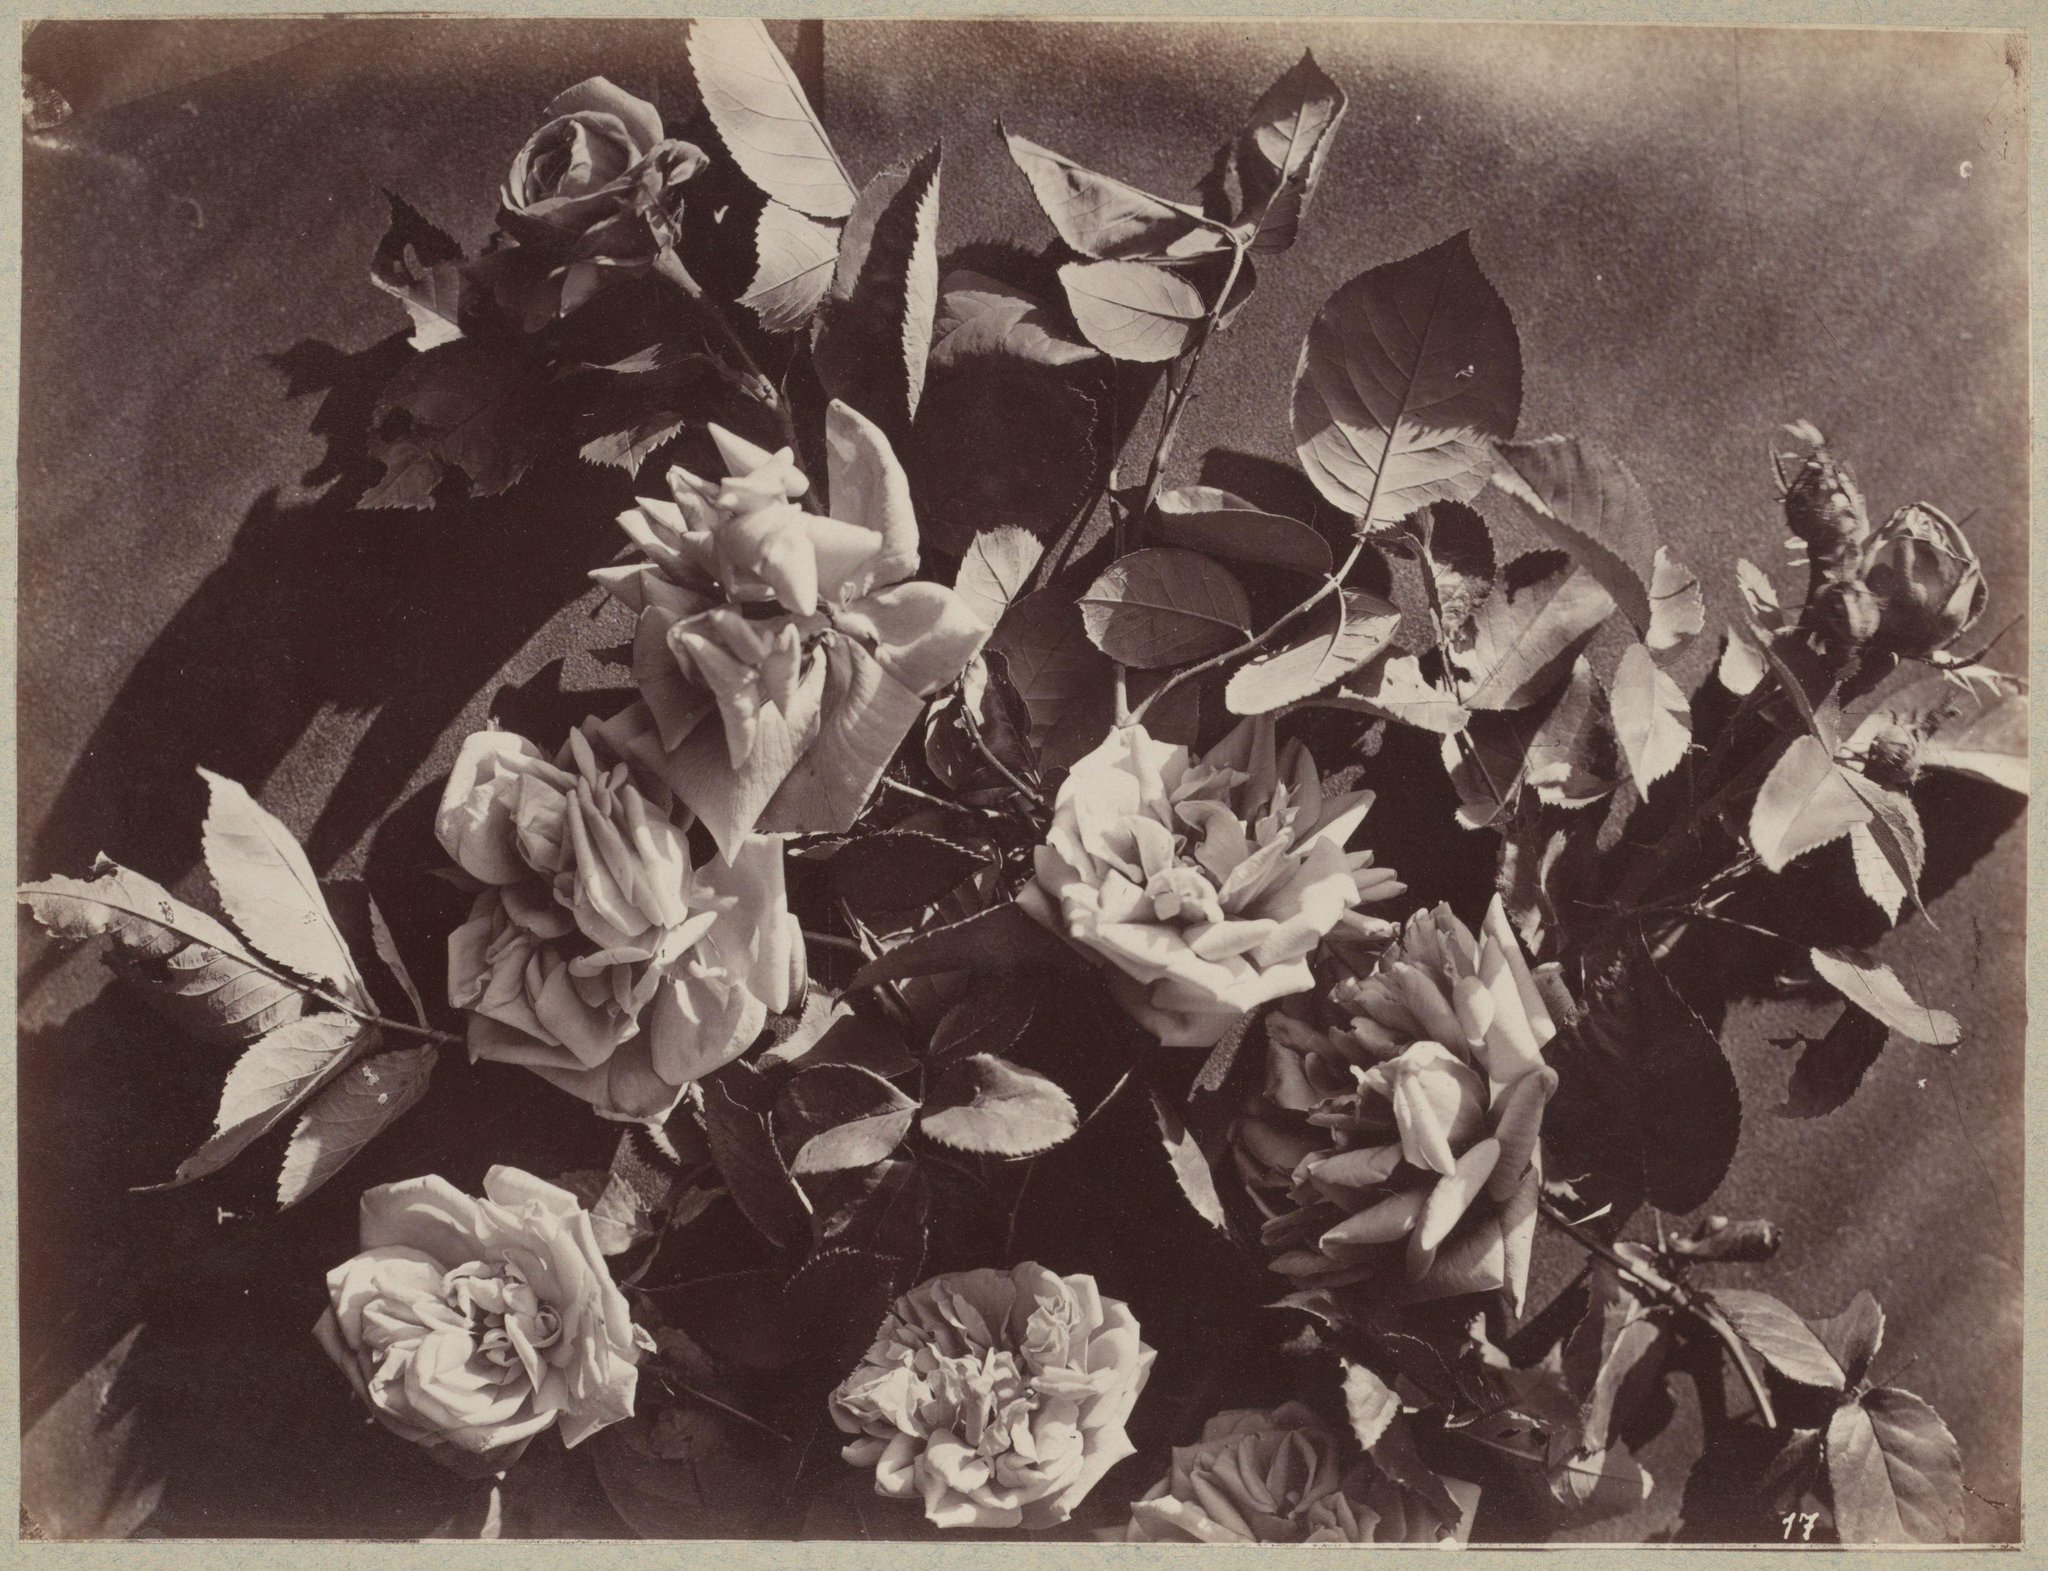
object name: photograph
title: Bloemstudie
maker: a. calavas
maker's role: publisher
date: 1875-1895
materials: cardboard, photographic support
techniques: albumen print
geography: paris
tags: flowers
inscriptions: collector's mark: Lugt 3937, number: ‘17’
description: Onderdeel van Verzamelband met foto's van bloemstudies.